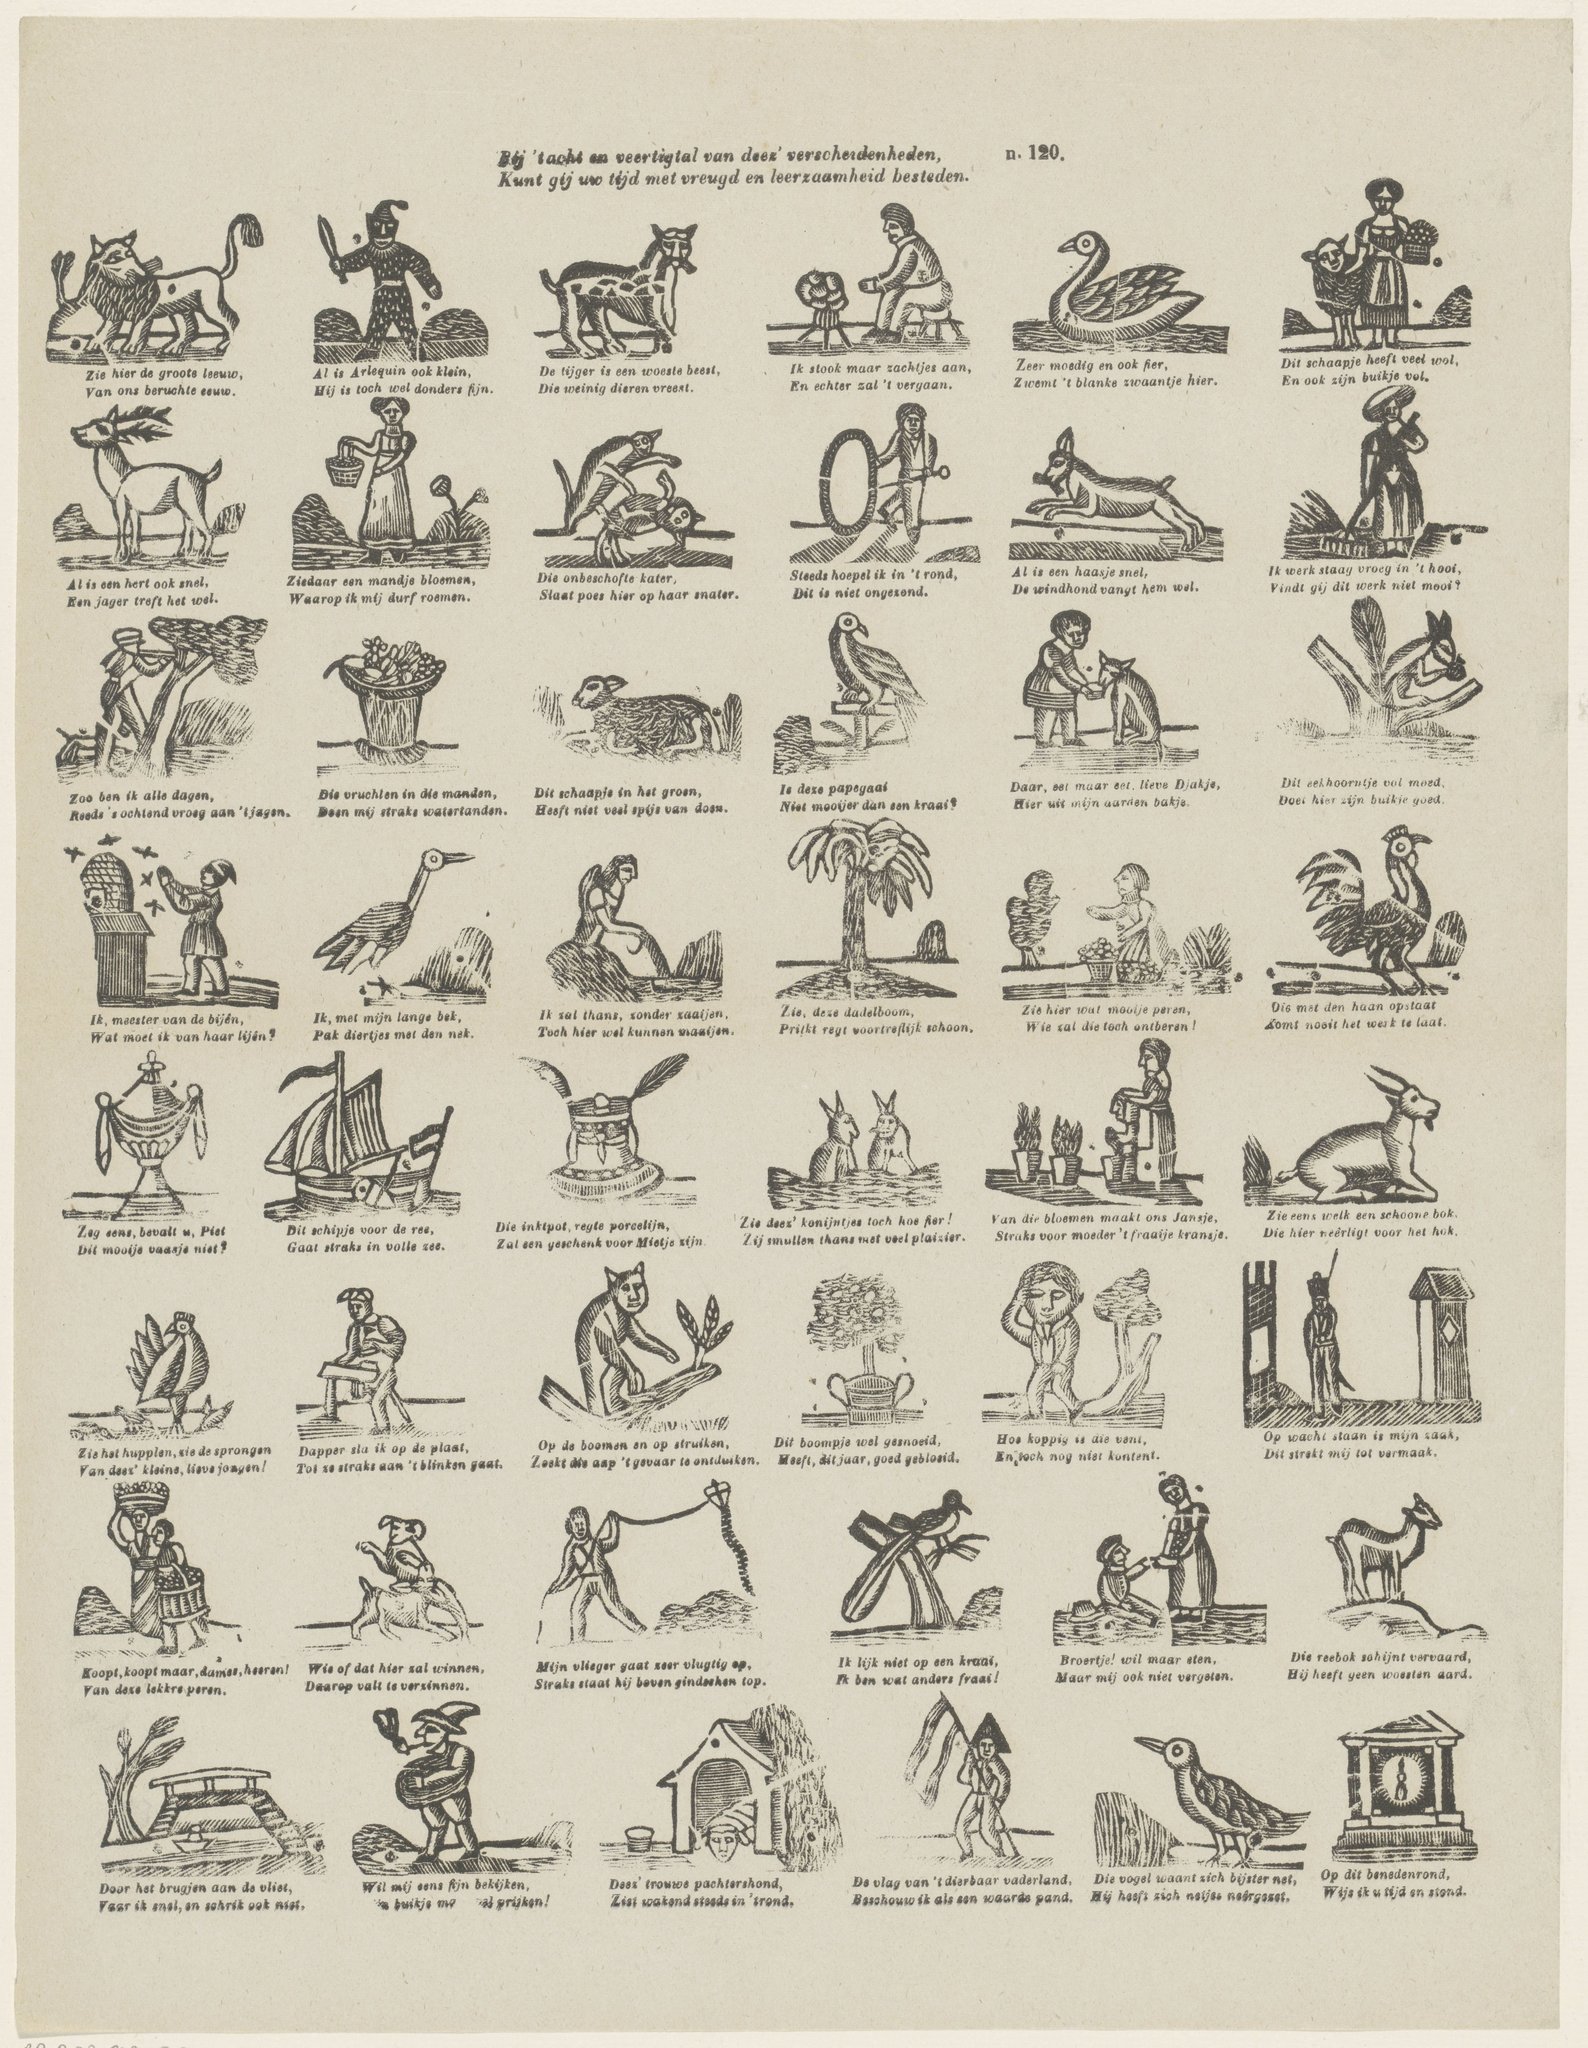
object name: print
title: By 't acht en veertigtal van deez' verscheidenheden, / Kunt gy uwe tyd met vreugd en leerzaemheid besteden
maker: Anonymous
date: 1856-1900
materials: paper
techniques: letterpress printing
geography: turnhout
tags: animals, ships (in general), characters (human types), (flying a) kite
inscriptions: collector's mark: Lugt 2760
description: Blad met 48 voorstellingen van figuren, dieren en voorwerpen. Onder elke afbeelding een tweeregelig vers. Genummerd rechtsboven: n. 120.